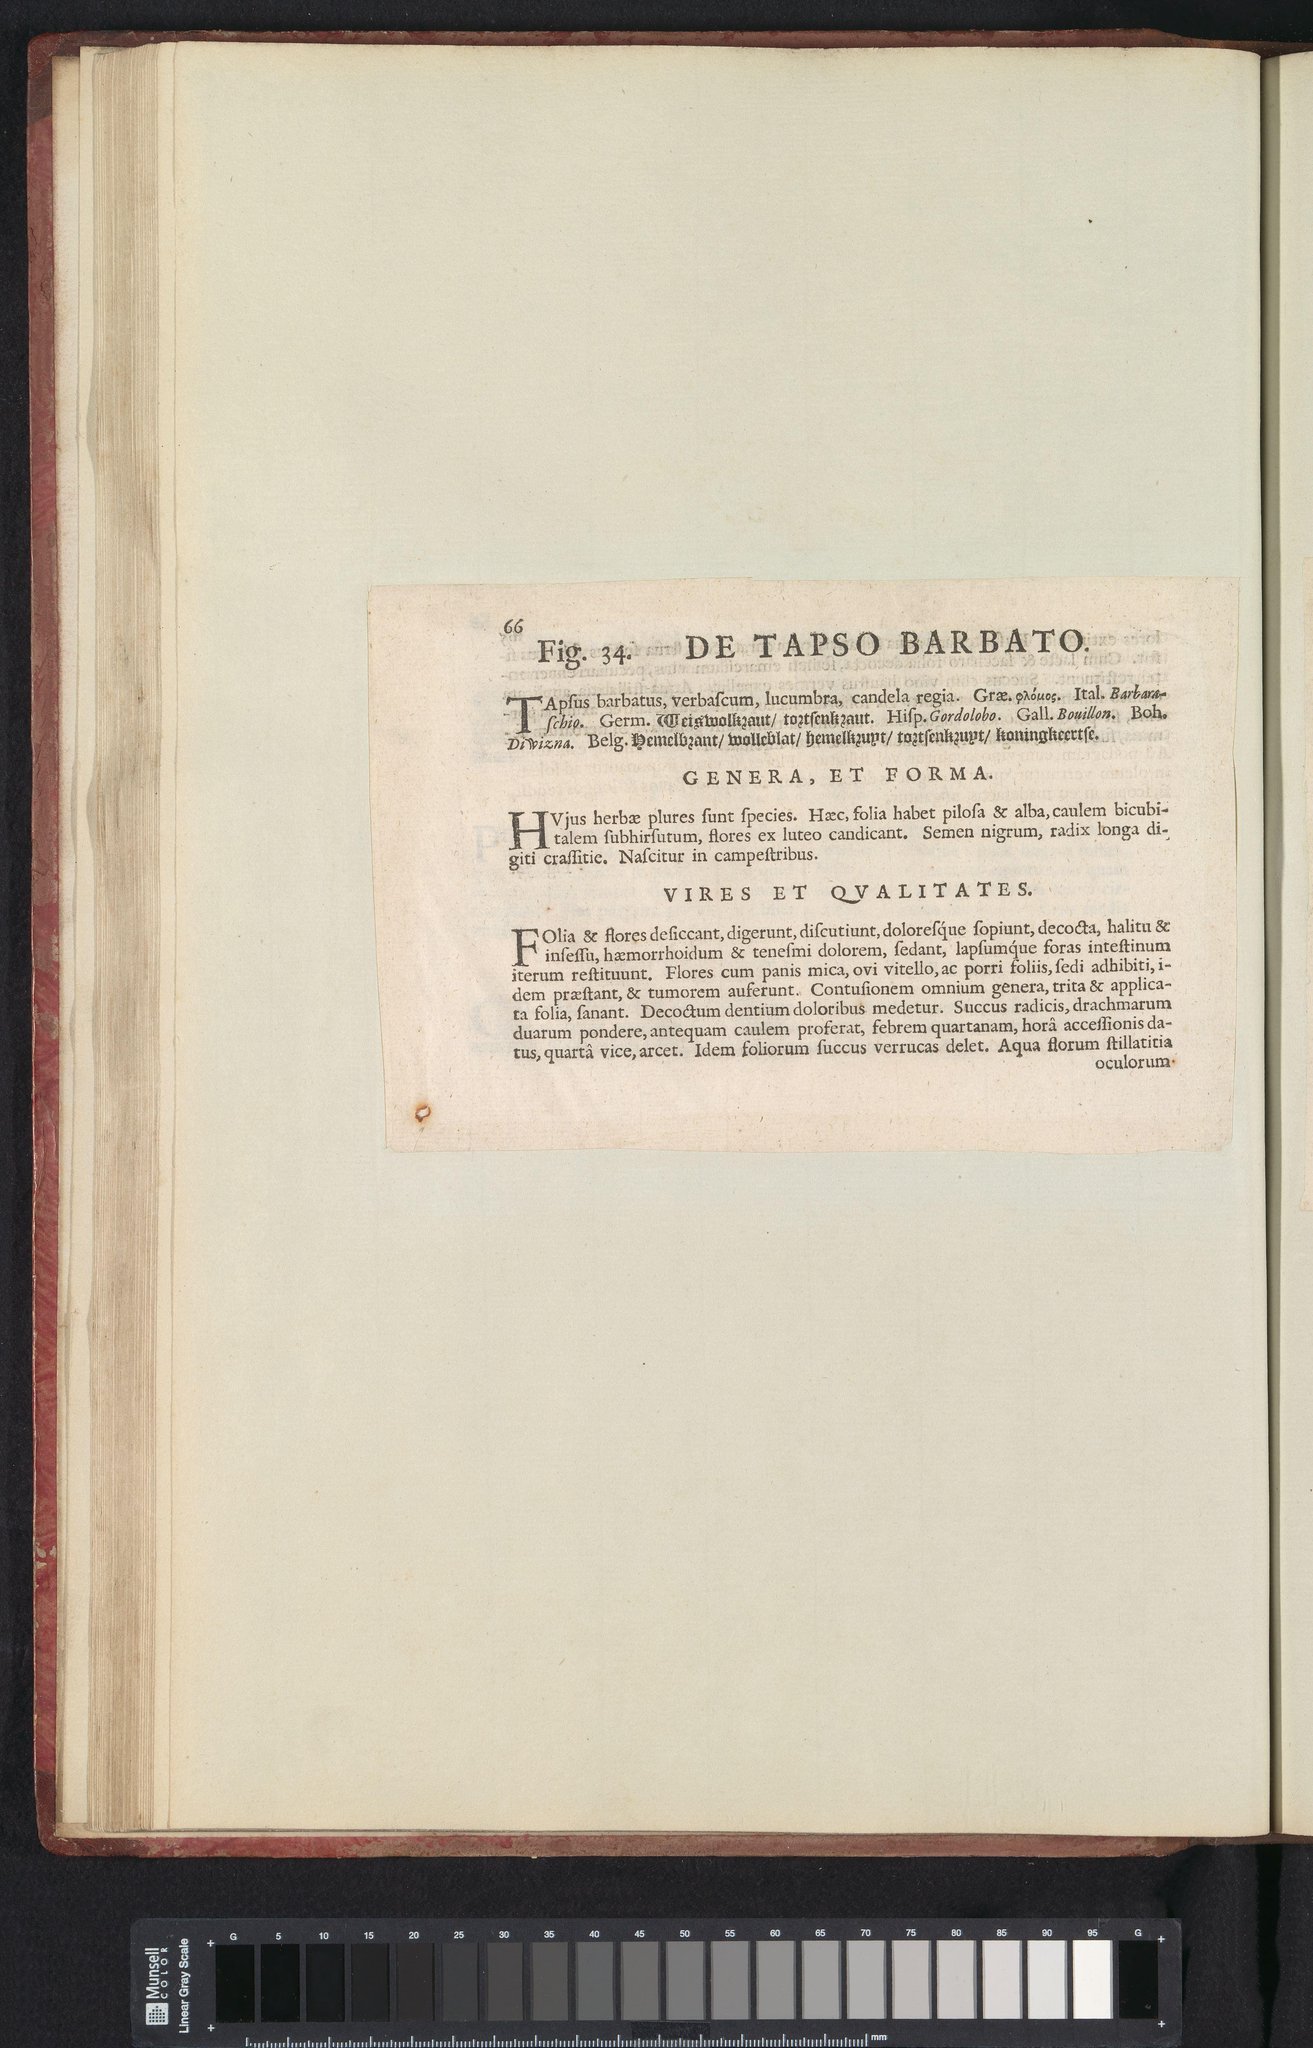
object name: text sheet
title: Fig. 34 'De Tapso Barbato' in De Boodts herbarium van 1640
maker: anselmus boëtius de boodt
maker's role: draughtsman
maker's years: 1550-1632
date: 1640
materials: ink, paper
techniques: letterpress printing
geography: bruges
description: Beschrijving bij Fig. 34 op p. 66 in: Anselmi Boëtii de Boot I.C. Brugensis & Rodolphi II. Imp. Roman. medici a cubiculis Florum, Herbarum, ac fructuum selectiorum icones, & vires pleraeque hactenus ignotæ. Onderdeel van het album met bladen en platen uit De Boodts herbarium van 1640. Het twaalfde van twaalf albums met aquarellen van dieren, vogels en planten bekend rond 1600, gemaakt in opdracht van keizer Rudolf II.